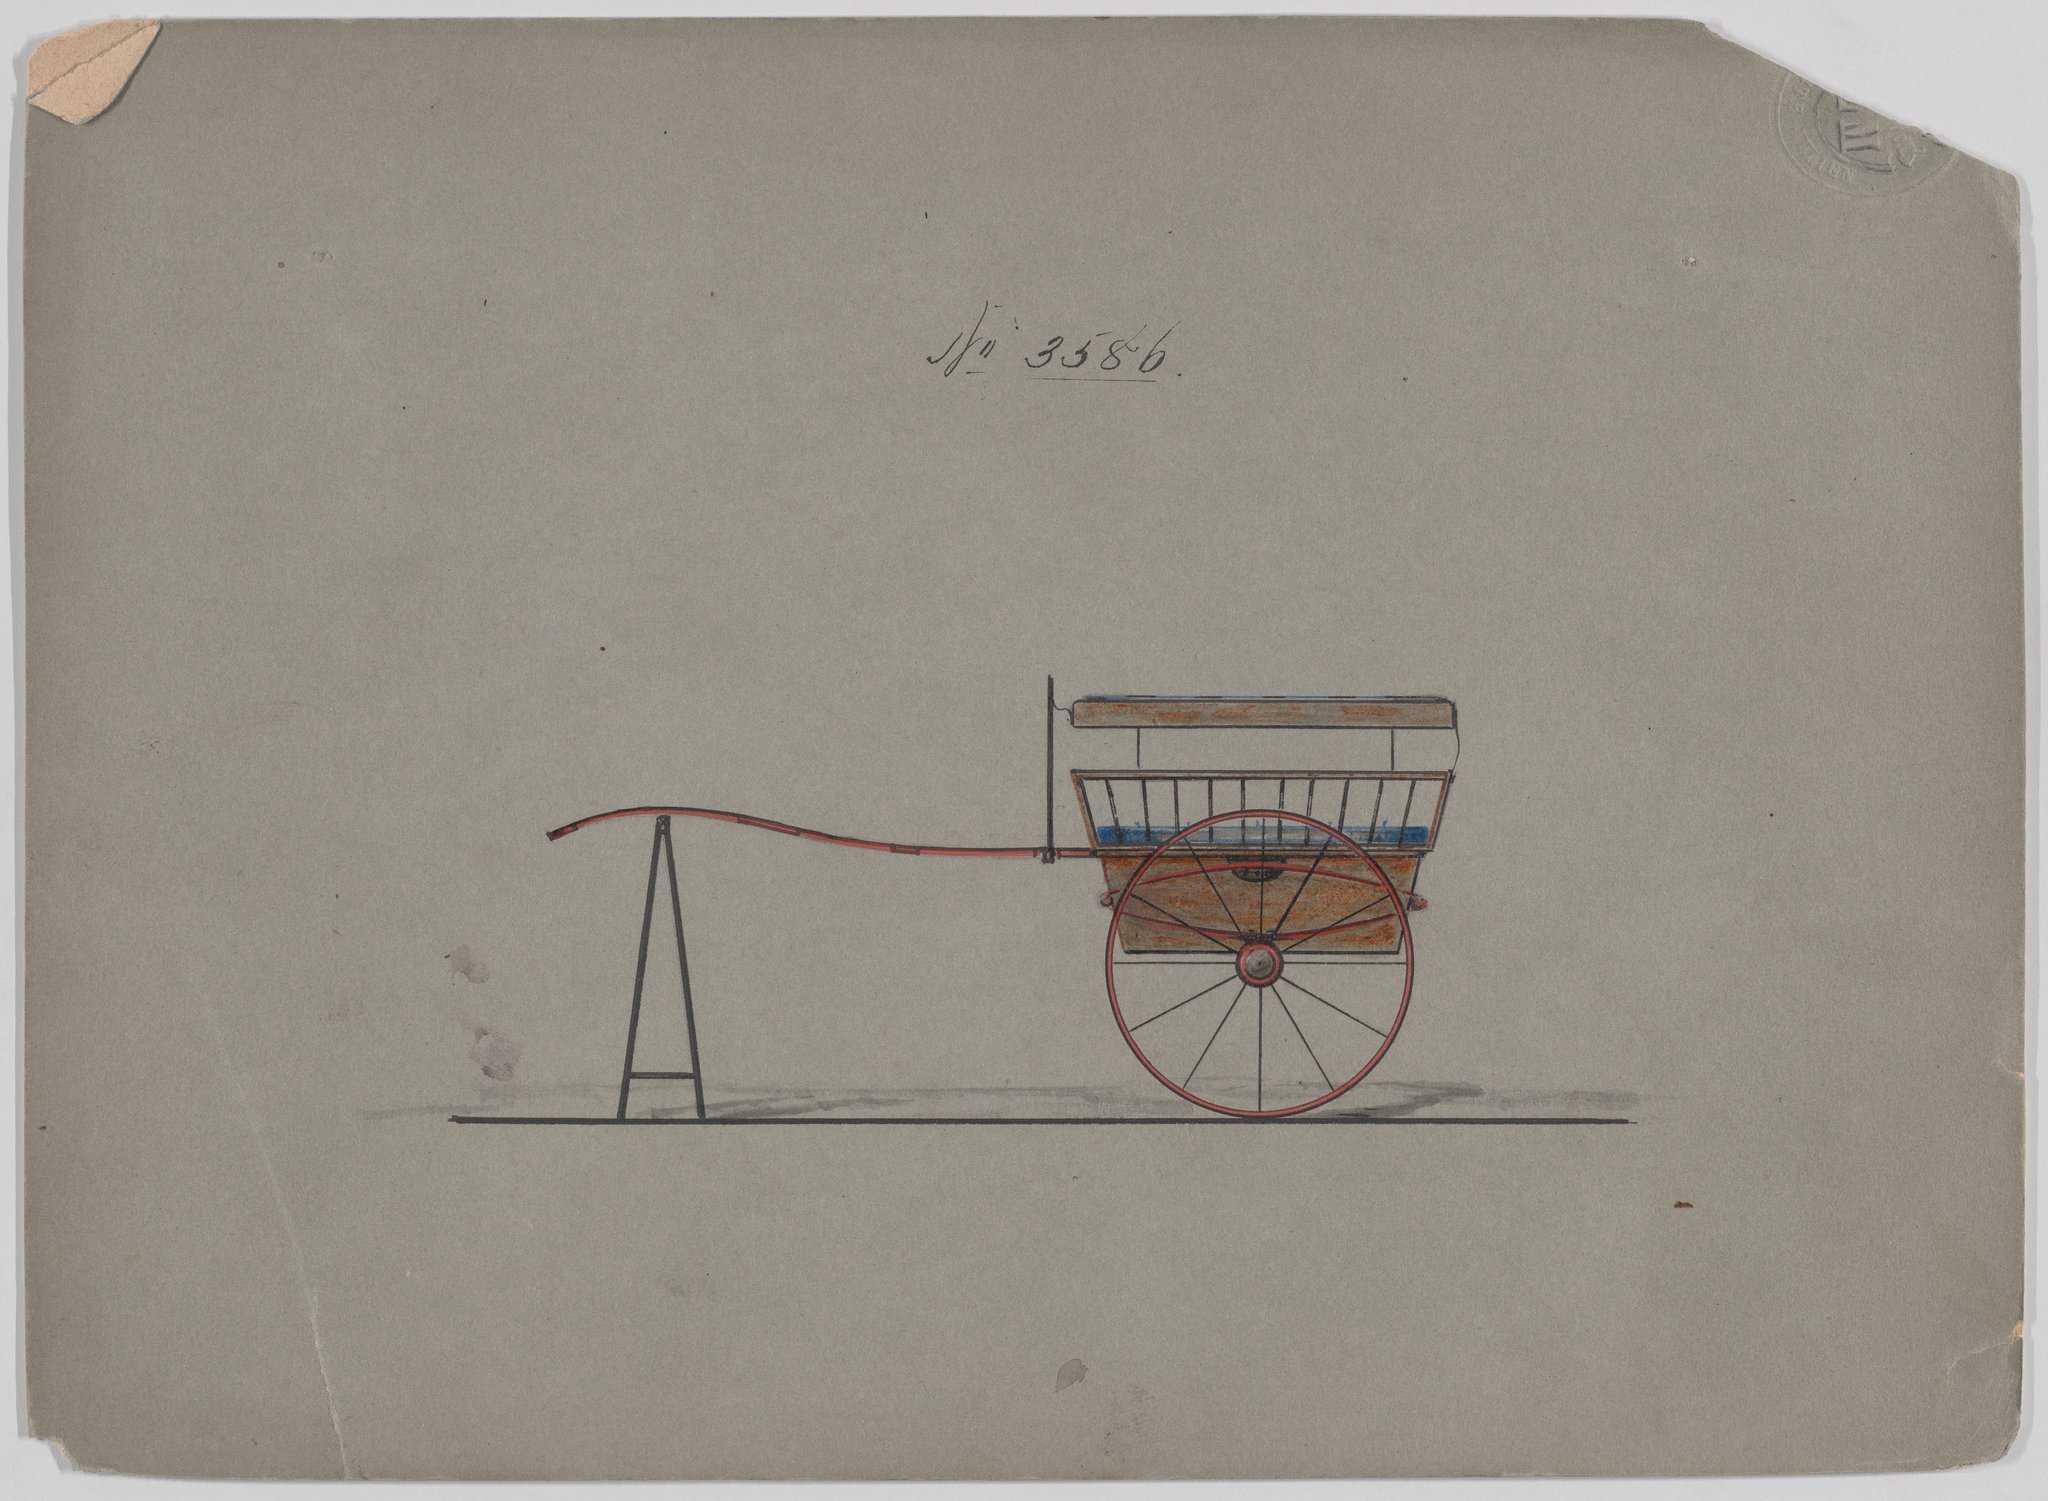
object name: drawing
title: Governess Cart/Tonneau #3586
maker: brewster & co.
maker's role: manufacturer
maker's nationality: american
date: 1880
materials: gouache, gum arabic, ink, watercolor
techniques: pen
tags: carriages